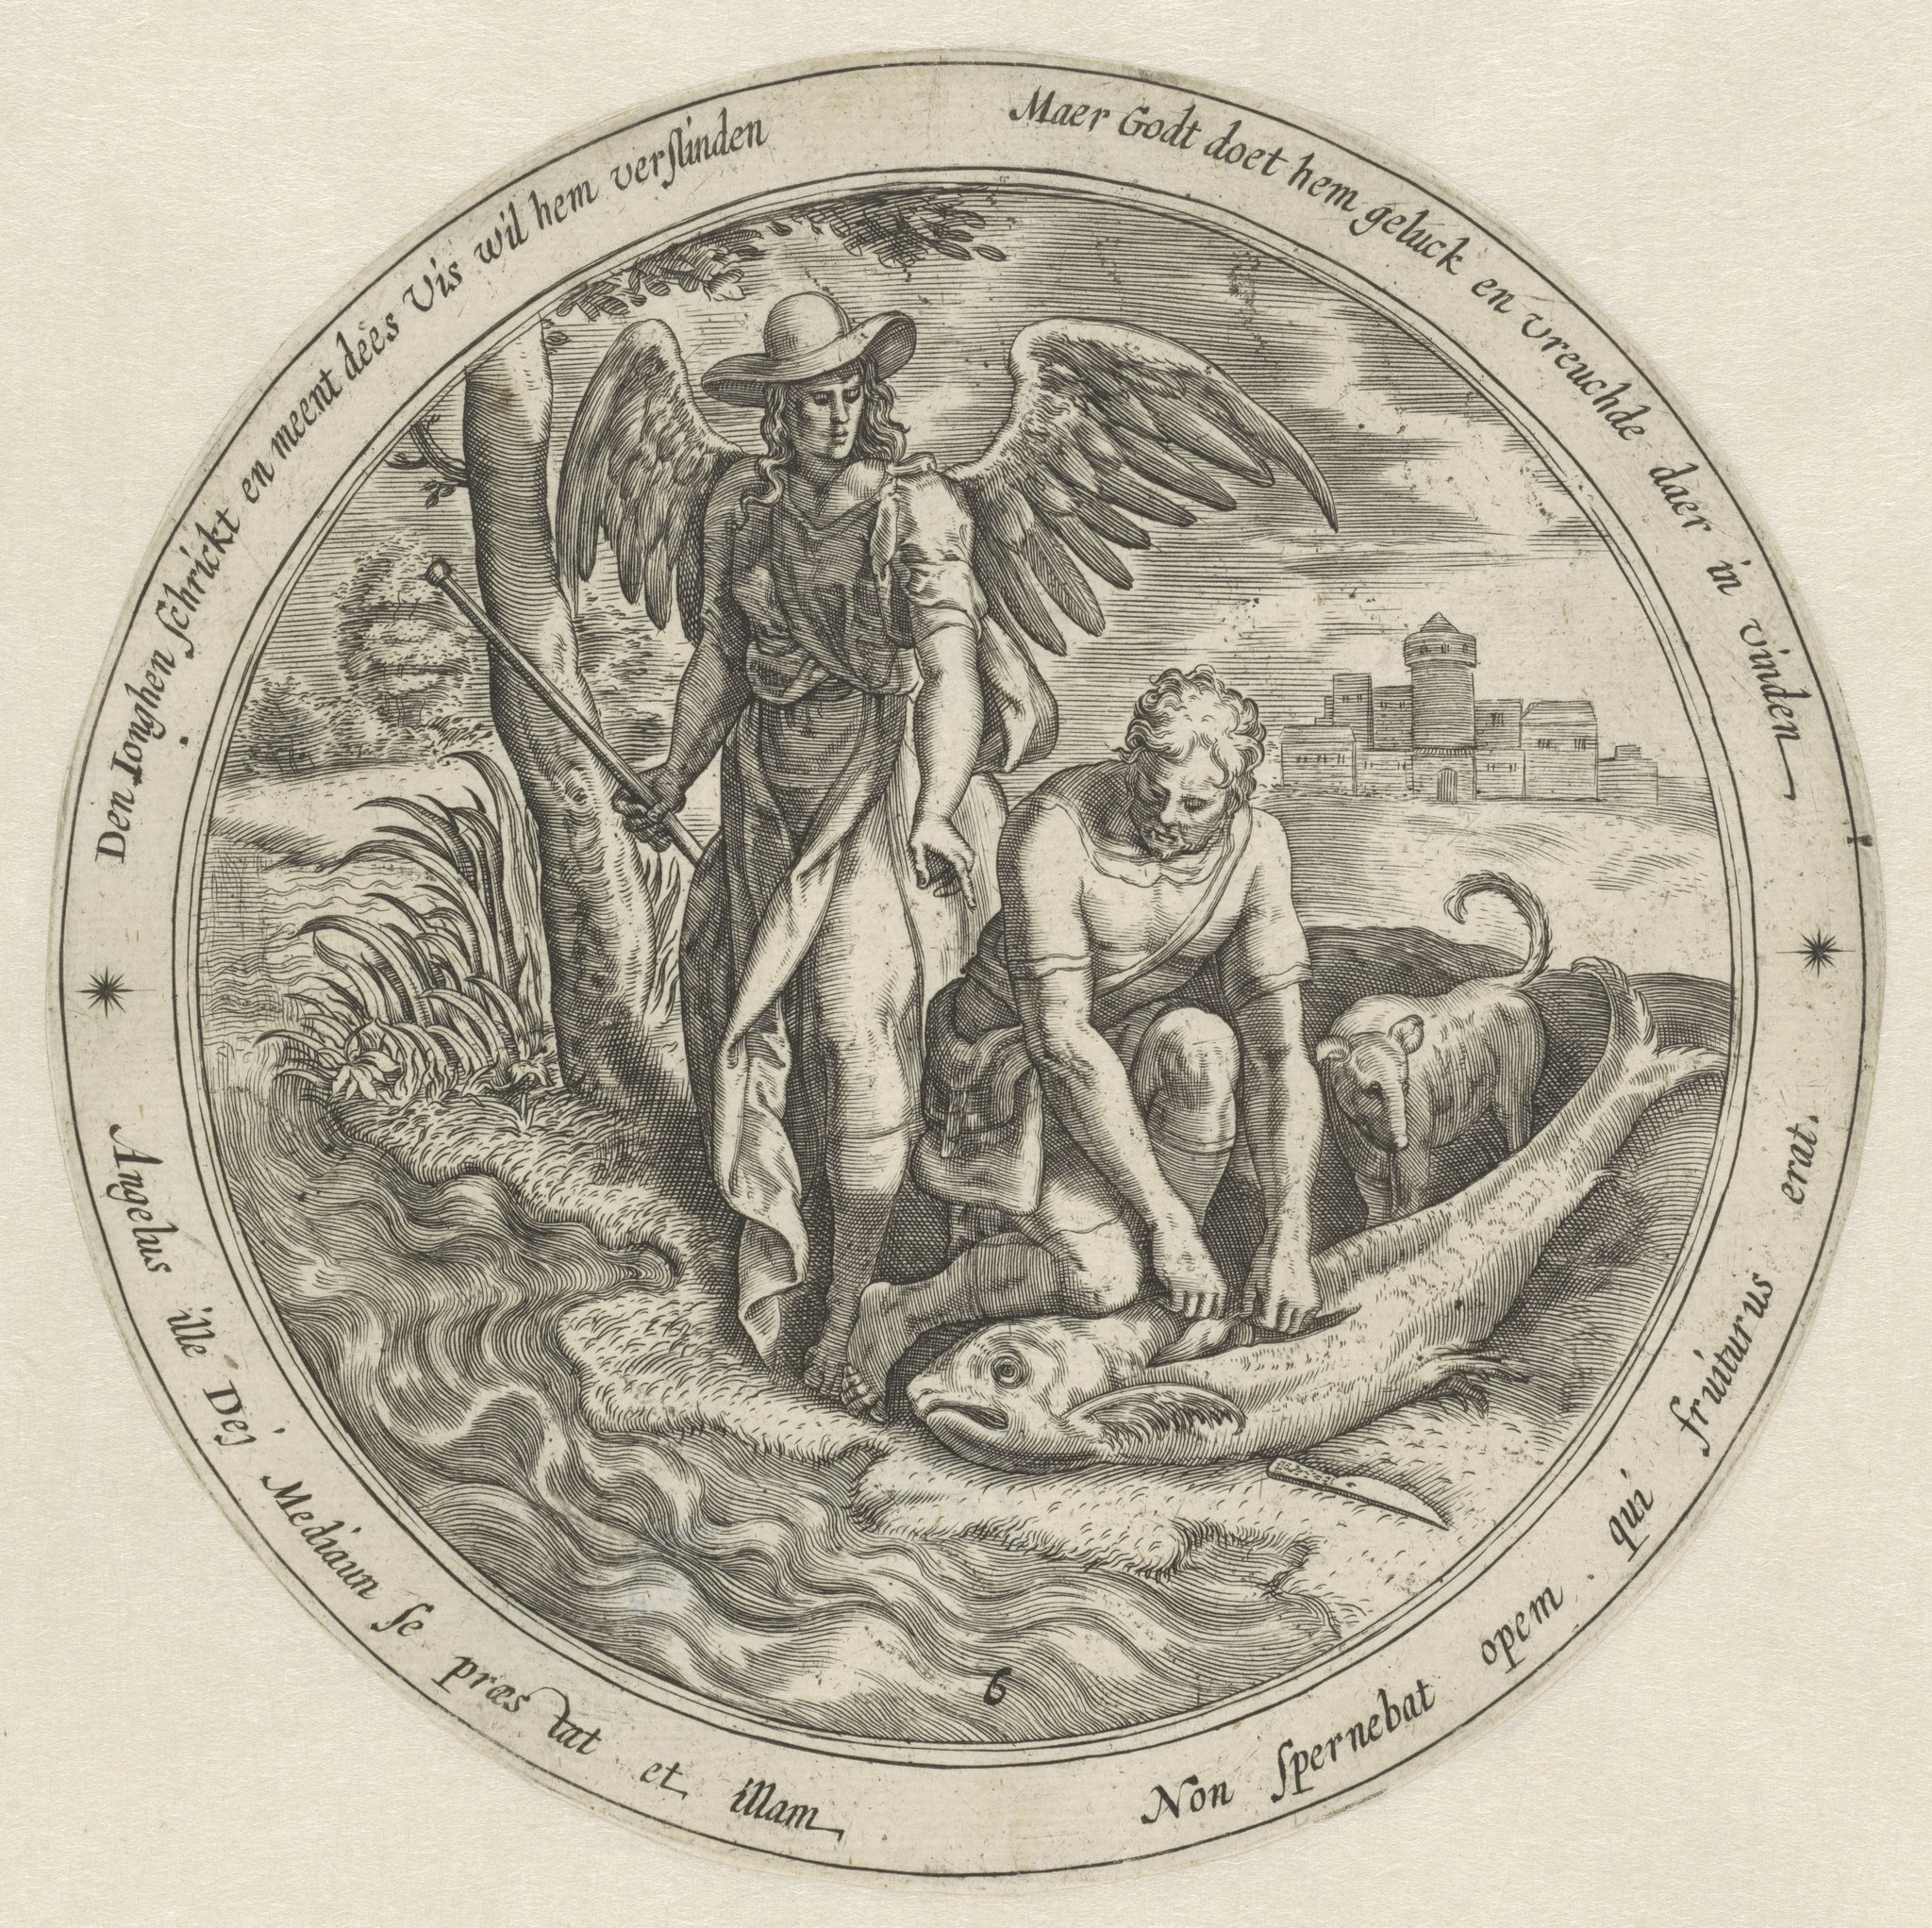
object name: print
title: Tobias verwijdert de ingewanden van de vis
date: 1601-1652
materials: paper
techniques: engraving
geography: netherlands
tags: the angel raphael tells tobias to cut the fish to pieces, tobias cuts up the fish and removes the heart, liver and gall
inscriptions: collector's mark: Lugt 2228, collector's mark: Lugt 1403b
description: Tobias haalt in opdracht van de aartsengel Rafaël het hart, de lever en de gal uit de vis. Naast Tobias staat zijn hond. Rond de voorstelling een randschrift in het Nederlands en in het Latijn.